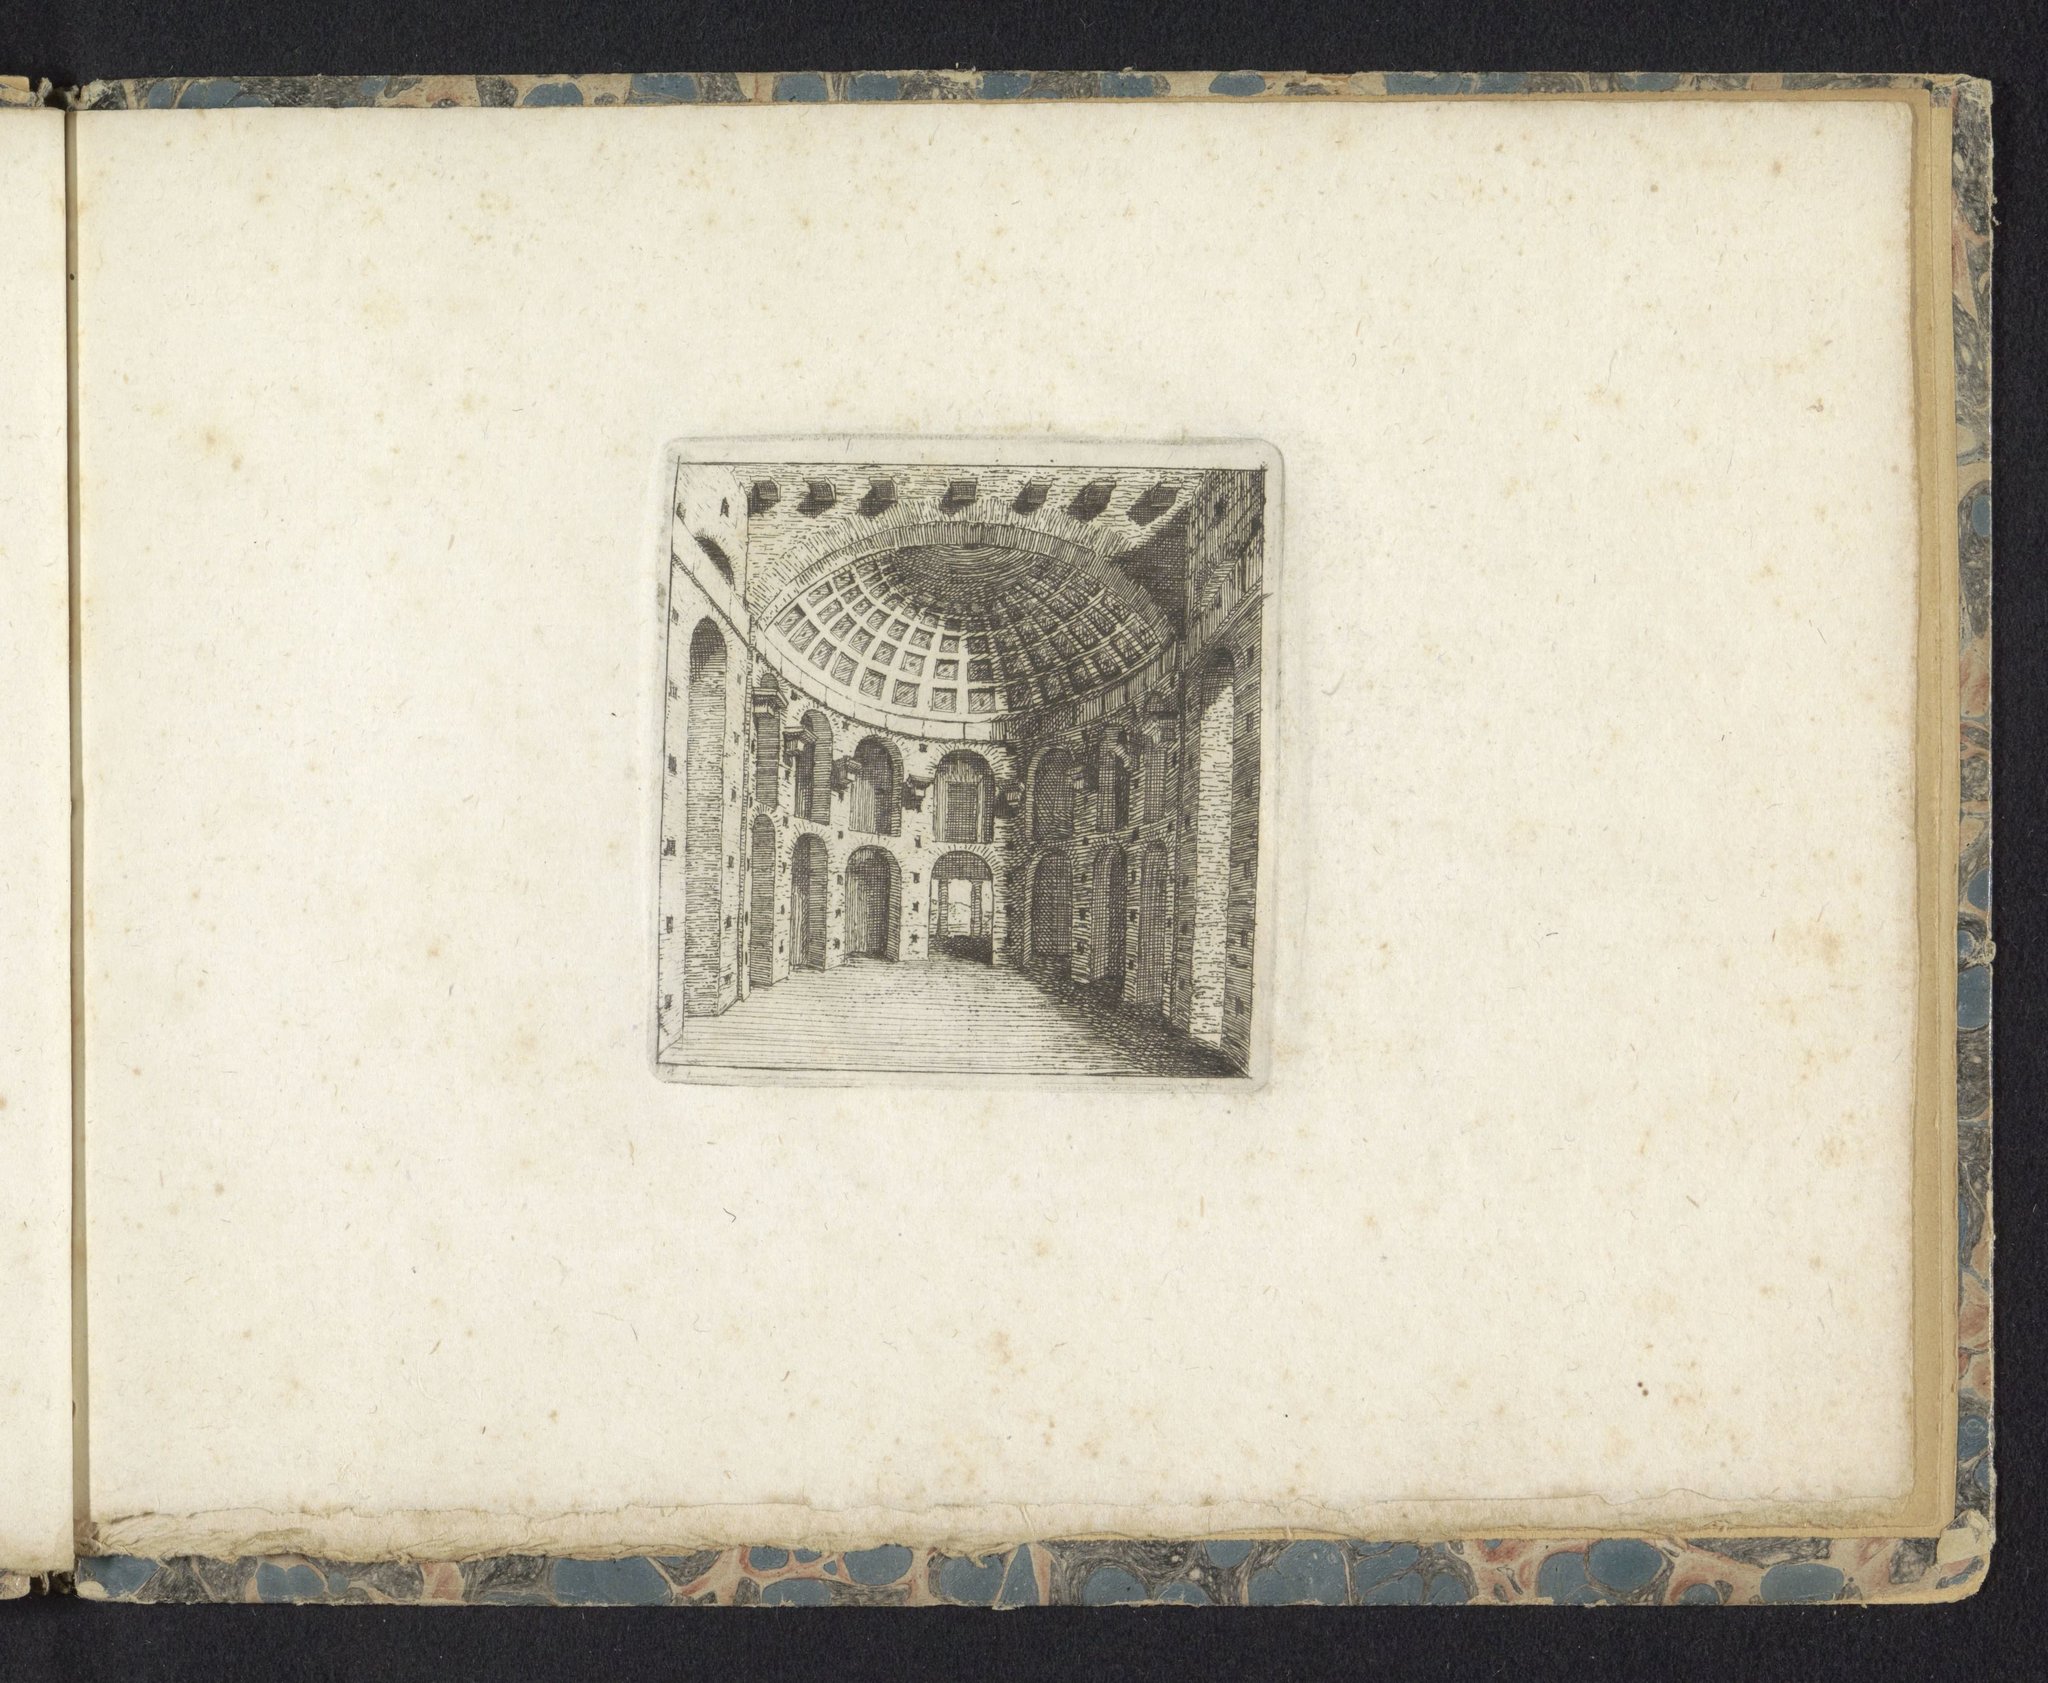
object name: album leaf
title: Decorontwerp met een ronde tempel met nissen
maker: Anonymous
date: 1750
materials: paper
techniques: etching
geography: italy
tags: set, scenery ~ stage, temple, shrine ~ roman religion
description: Deze prent maakt deel uit van een reeks van ten minste dertien prenten met decorontwerpen.